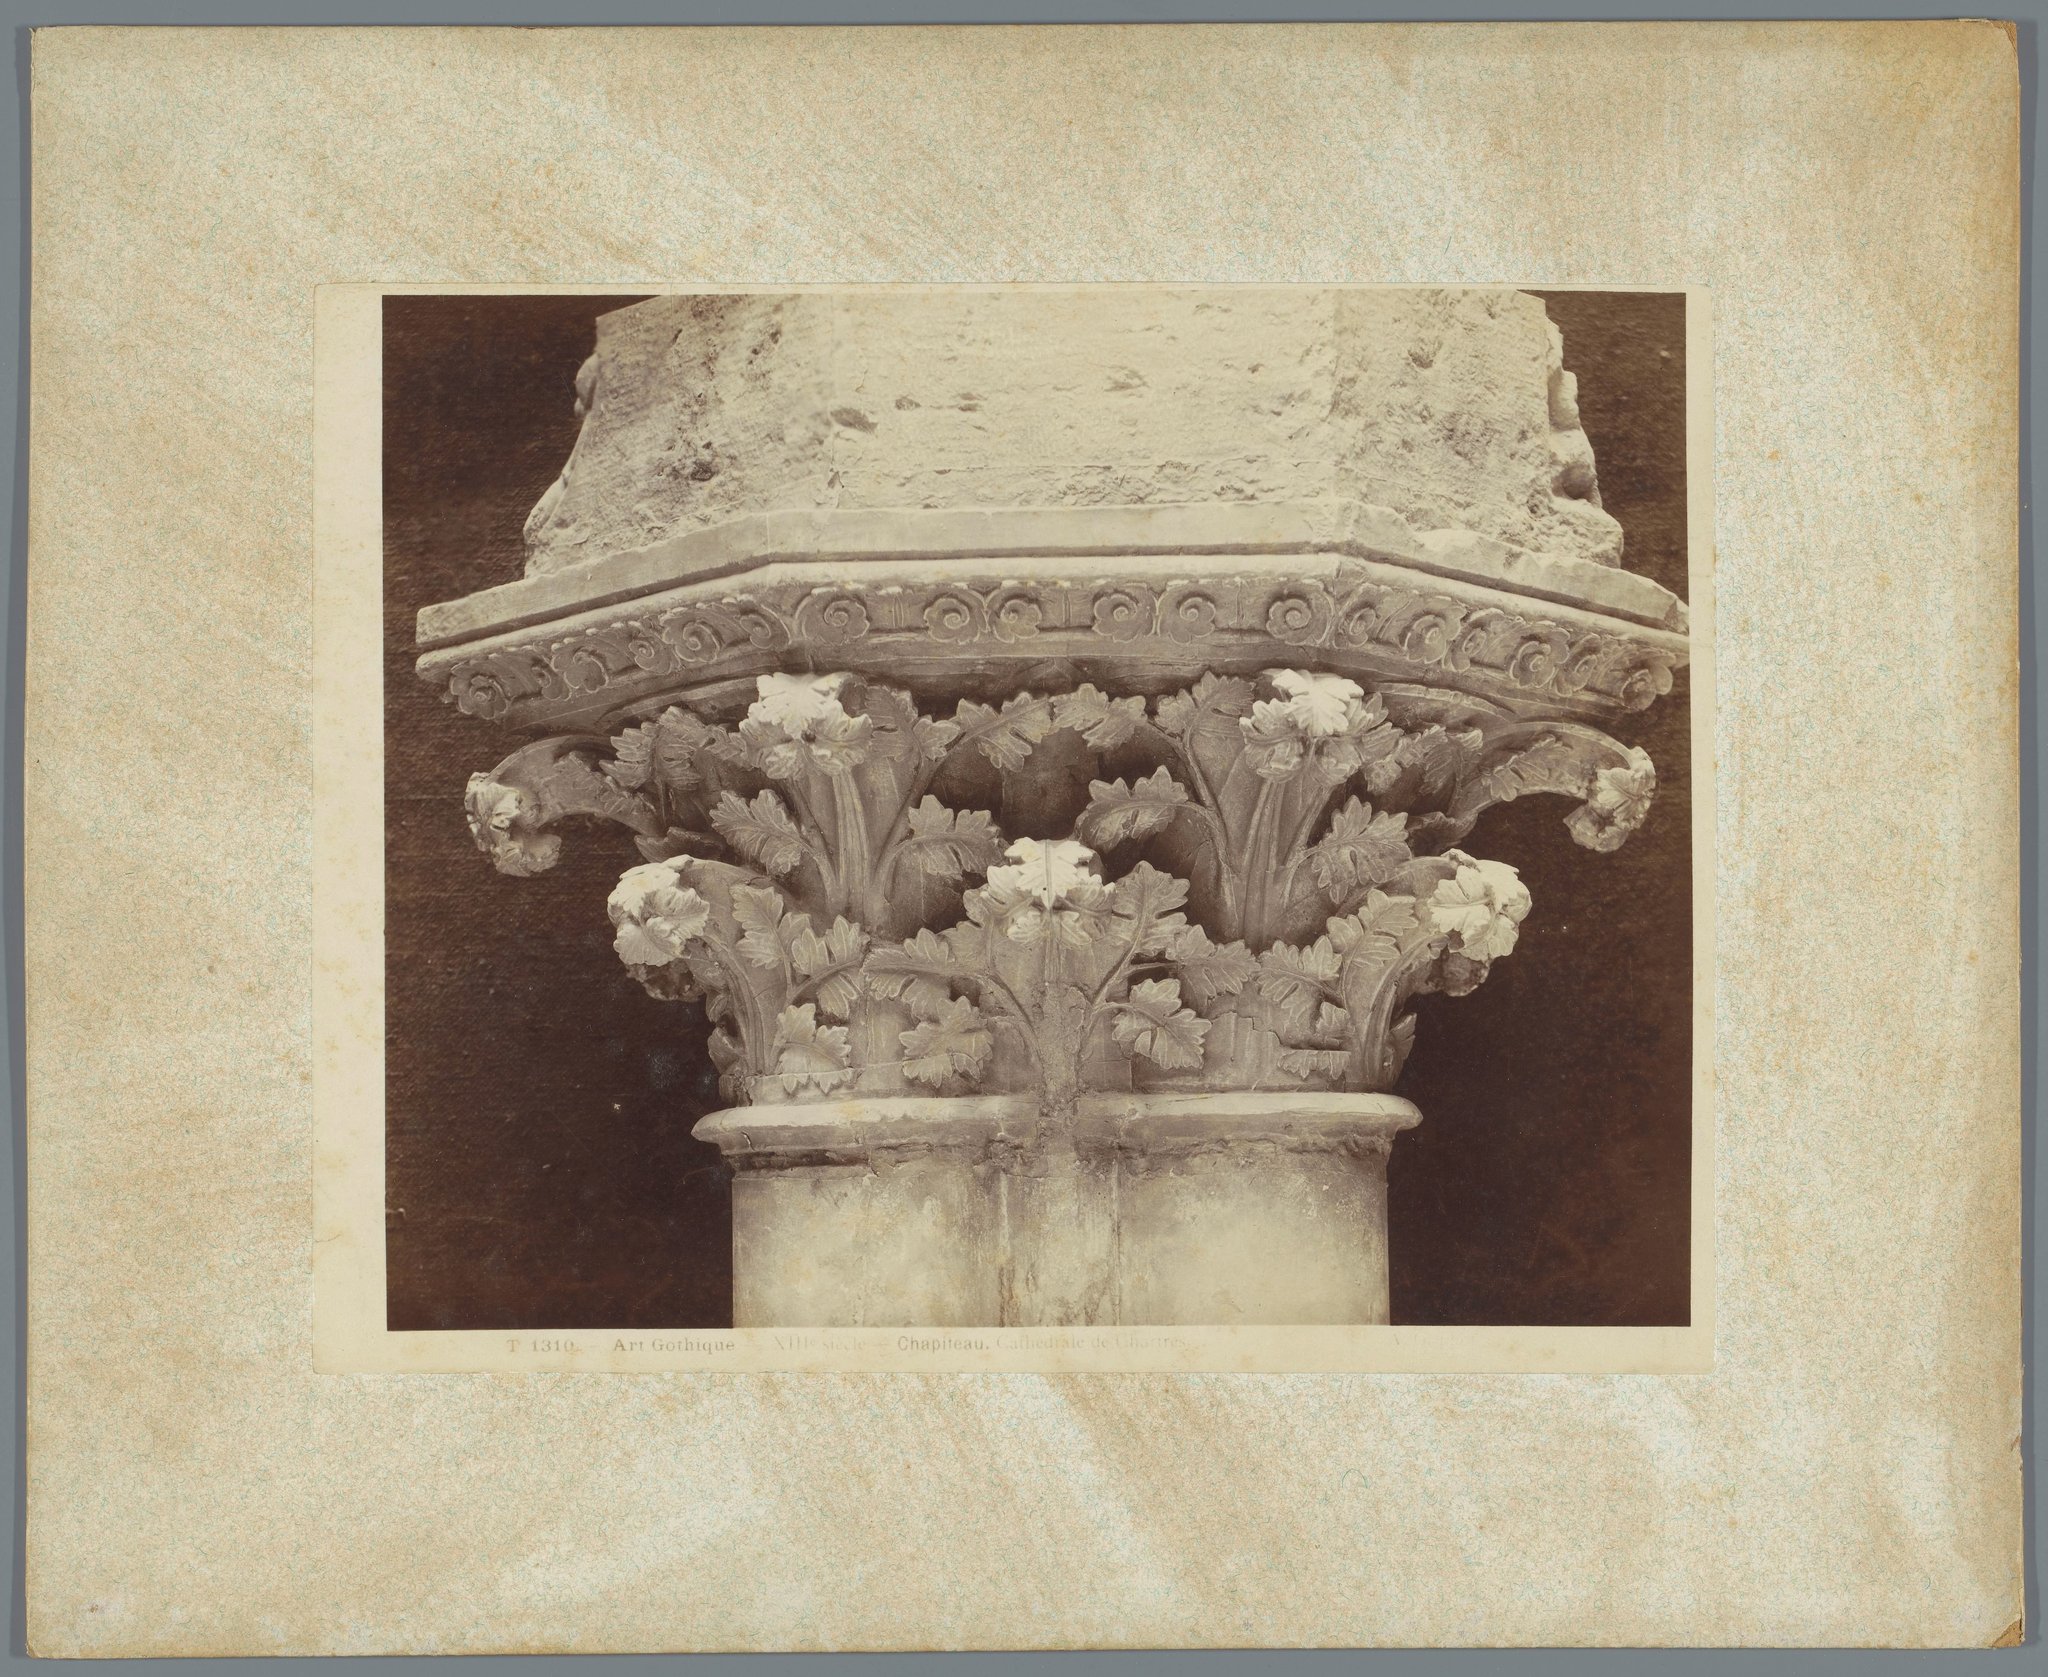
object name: photograph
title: Kapiteel van de Kathedraal van Chartres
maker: adolphe giraudon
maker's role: publisher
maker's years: 1849-1929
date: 1875-1900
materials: cardboard, photographic support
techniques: albumen print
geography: chartres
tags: capital (~ column, pillar), sculpture (+ relief ~ sculpture)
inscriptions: number: ‘T 1310’, collector's mark: ‘RIJKS-NORMAALSCHOOL voor TEEKENONDERWIJZERS AMSTERDAM’